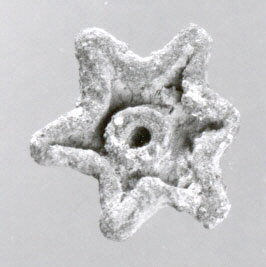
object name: stamp seal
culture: bactria-margiana archaeological complex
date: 2333-1668 BCE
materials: copper alloy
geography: bactria-margiana